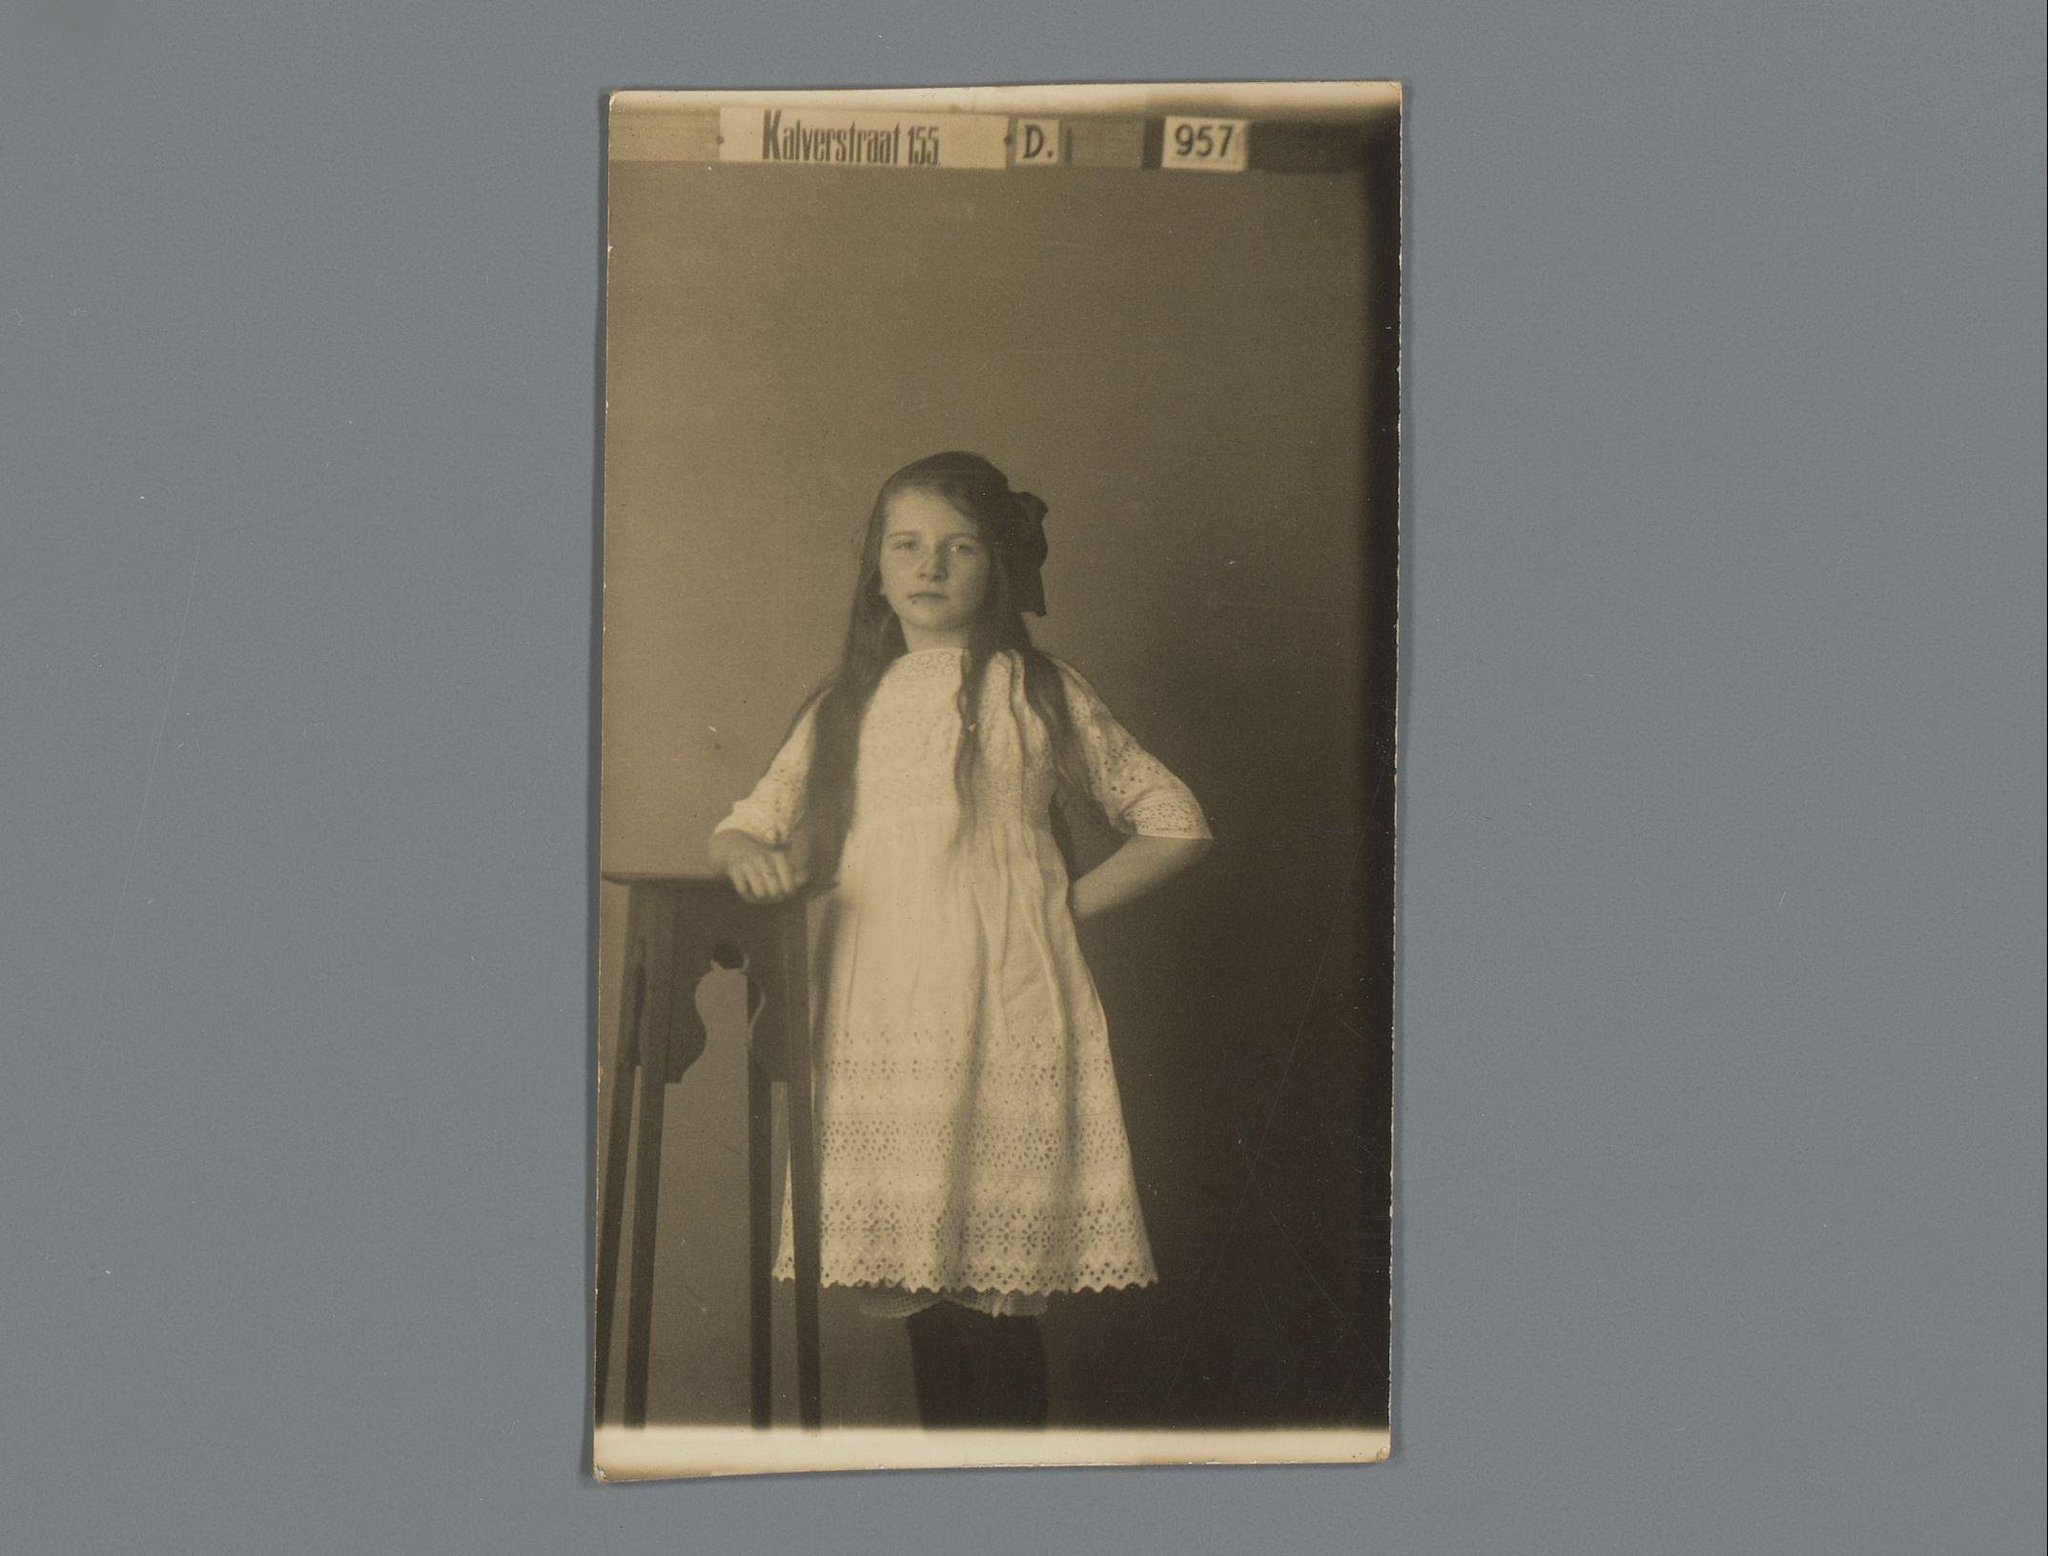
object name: snapshot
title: Portret van Jeannette Oostdam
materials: paper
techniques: gelatin silver print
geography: amsterdam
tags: historical persons, girl (child between toddler and youth)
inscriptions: address: ‘Kalverstraat 155’, name: ‘Jeanette Oostdam’